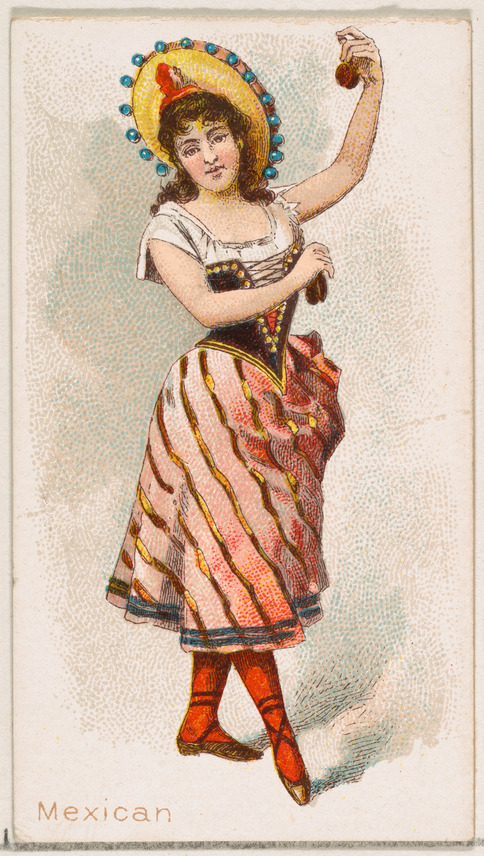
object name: print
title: Mexican Dancer, from the Dancing Women series (N186) issued by Wm. S. Kimball & Co.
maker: william s. kimball & company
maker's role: publisher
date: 1889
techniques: color lithograph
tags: women,dancers